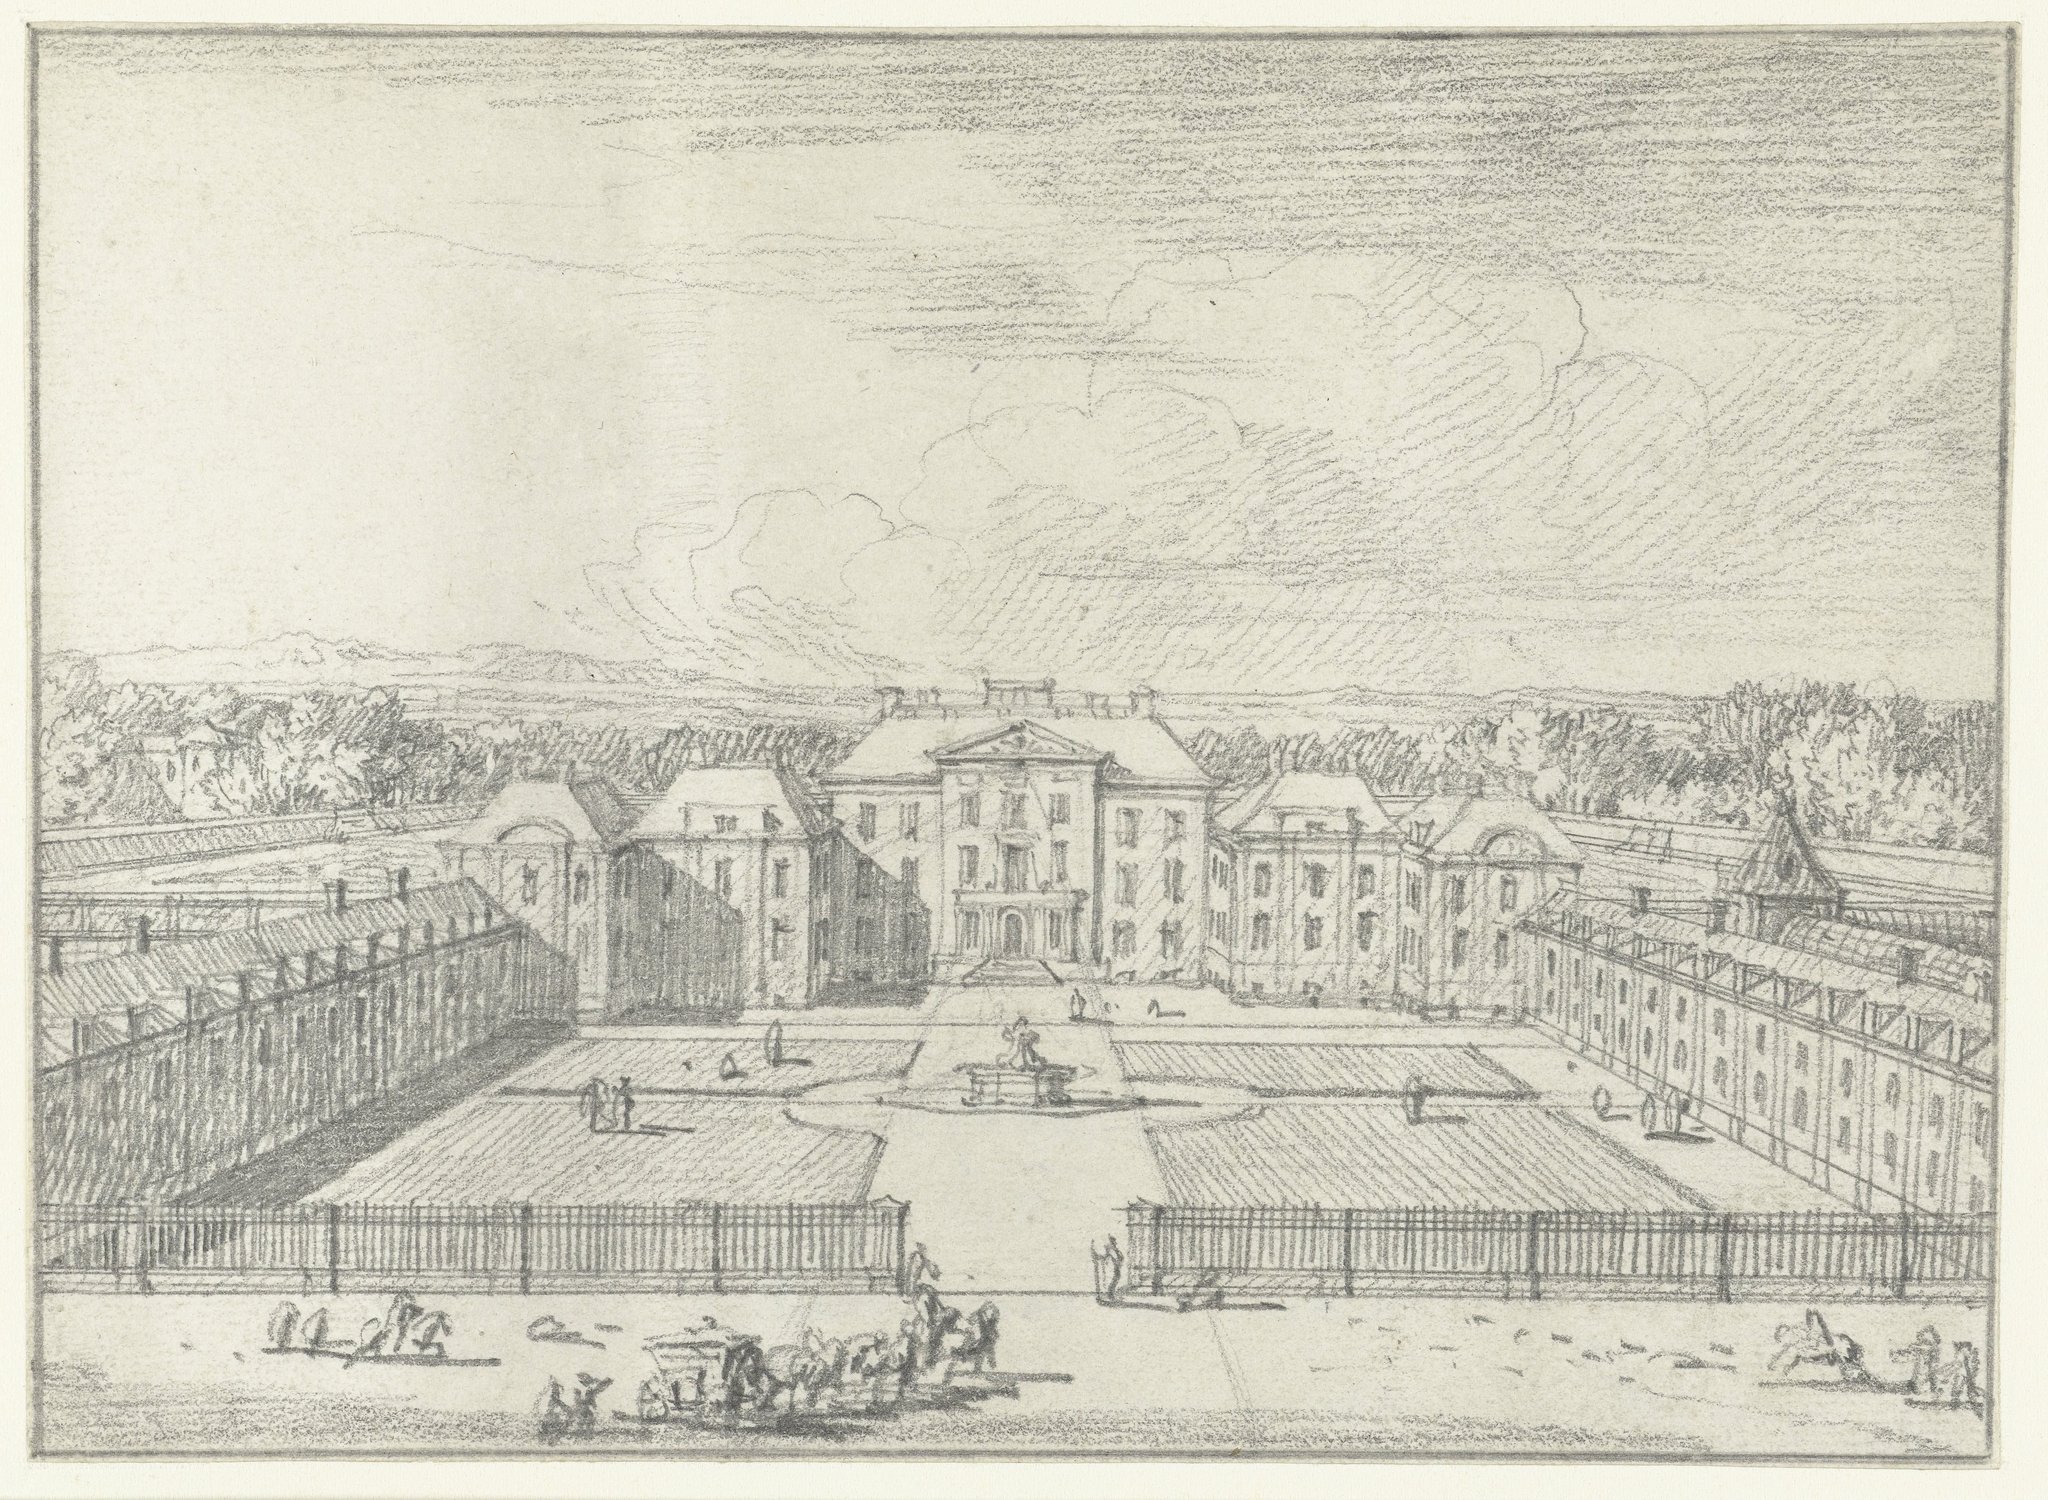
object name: drawing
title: Het Loo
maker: isaac de moucheron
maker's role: draughtsman, painter, print maker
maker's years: 1667-1744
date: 1677-1744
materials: paper, pencil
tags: castle